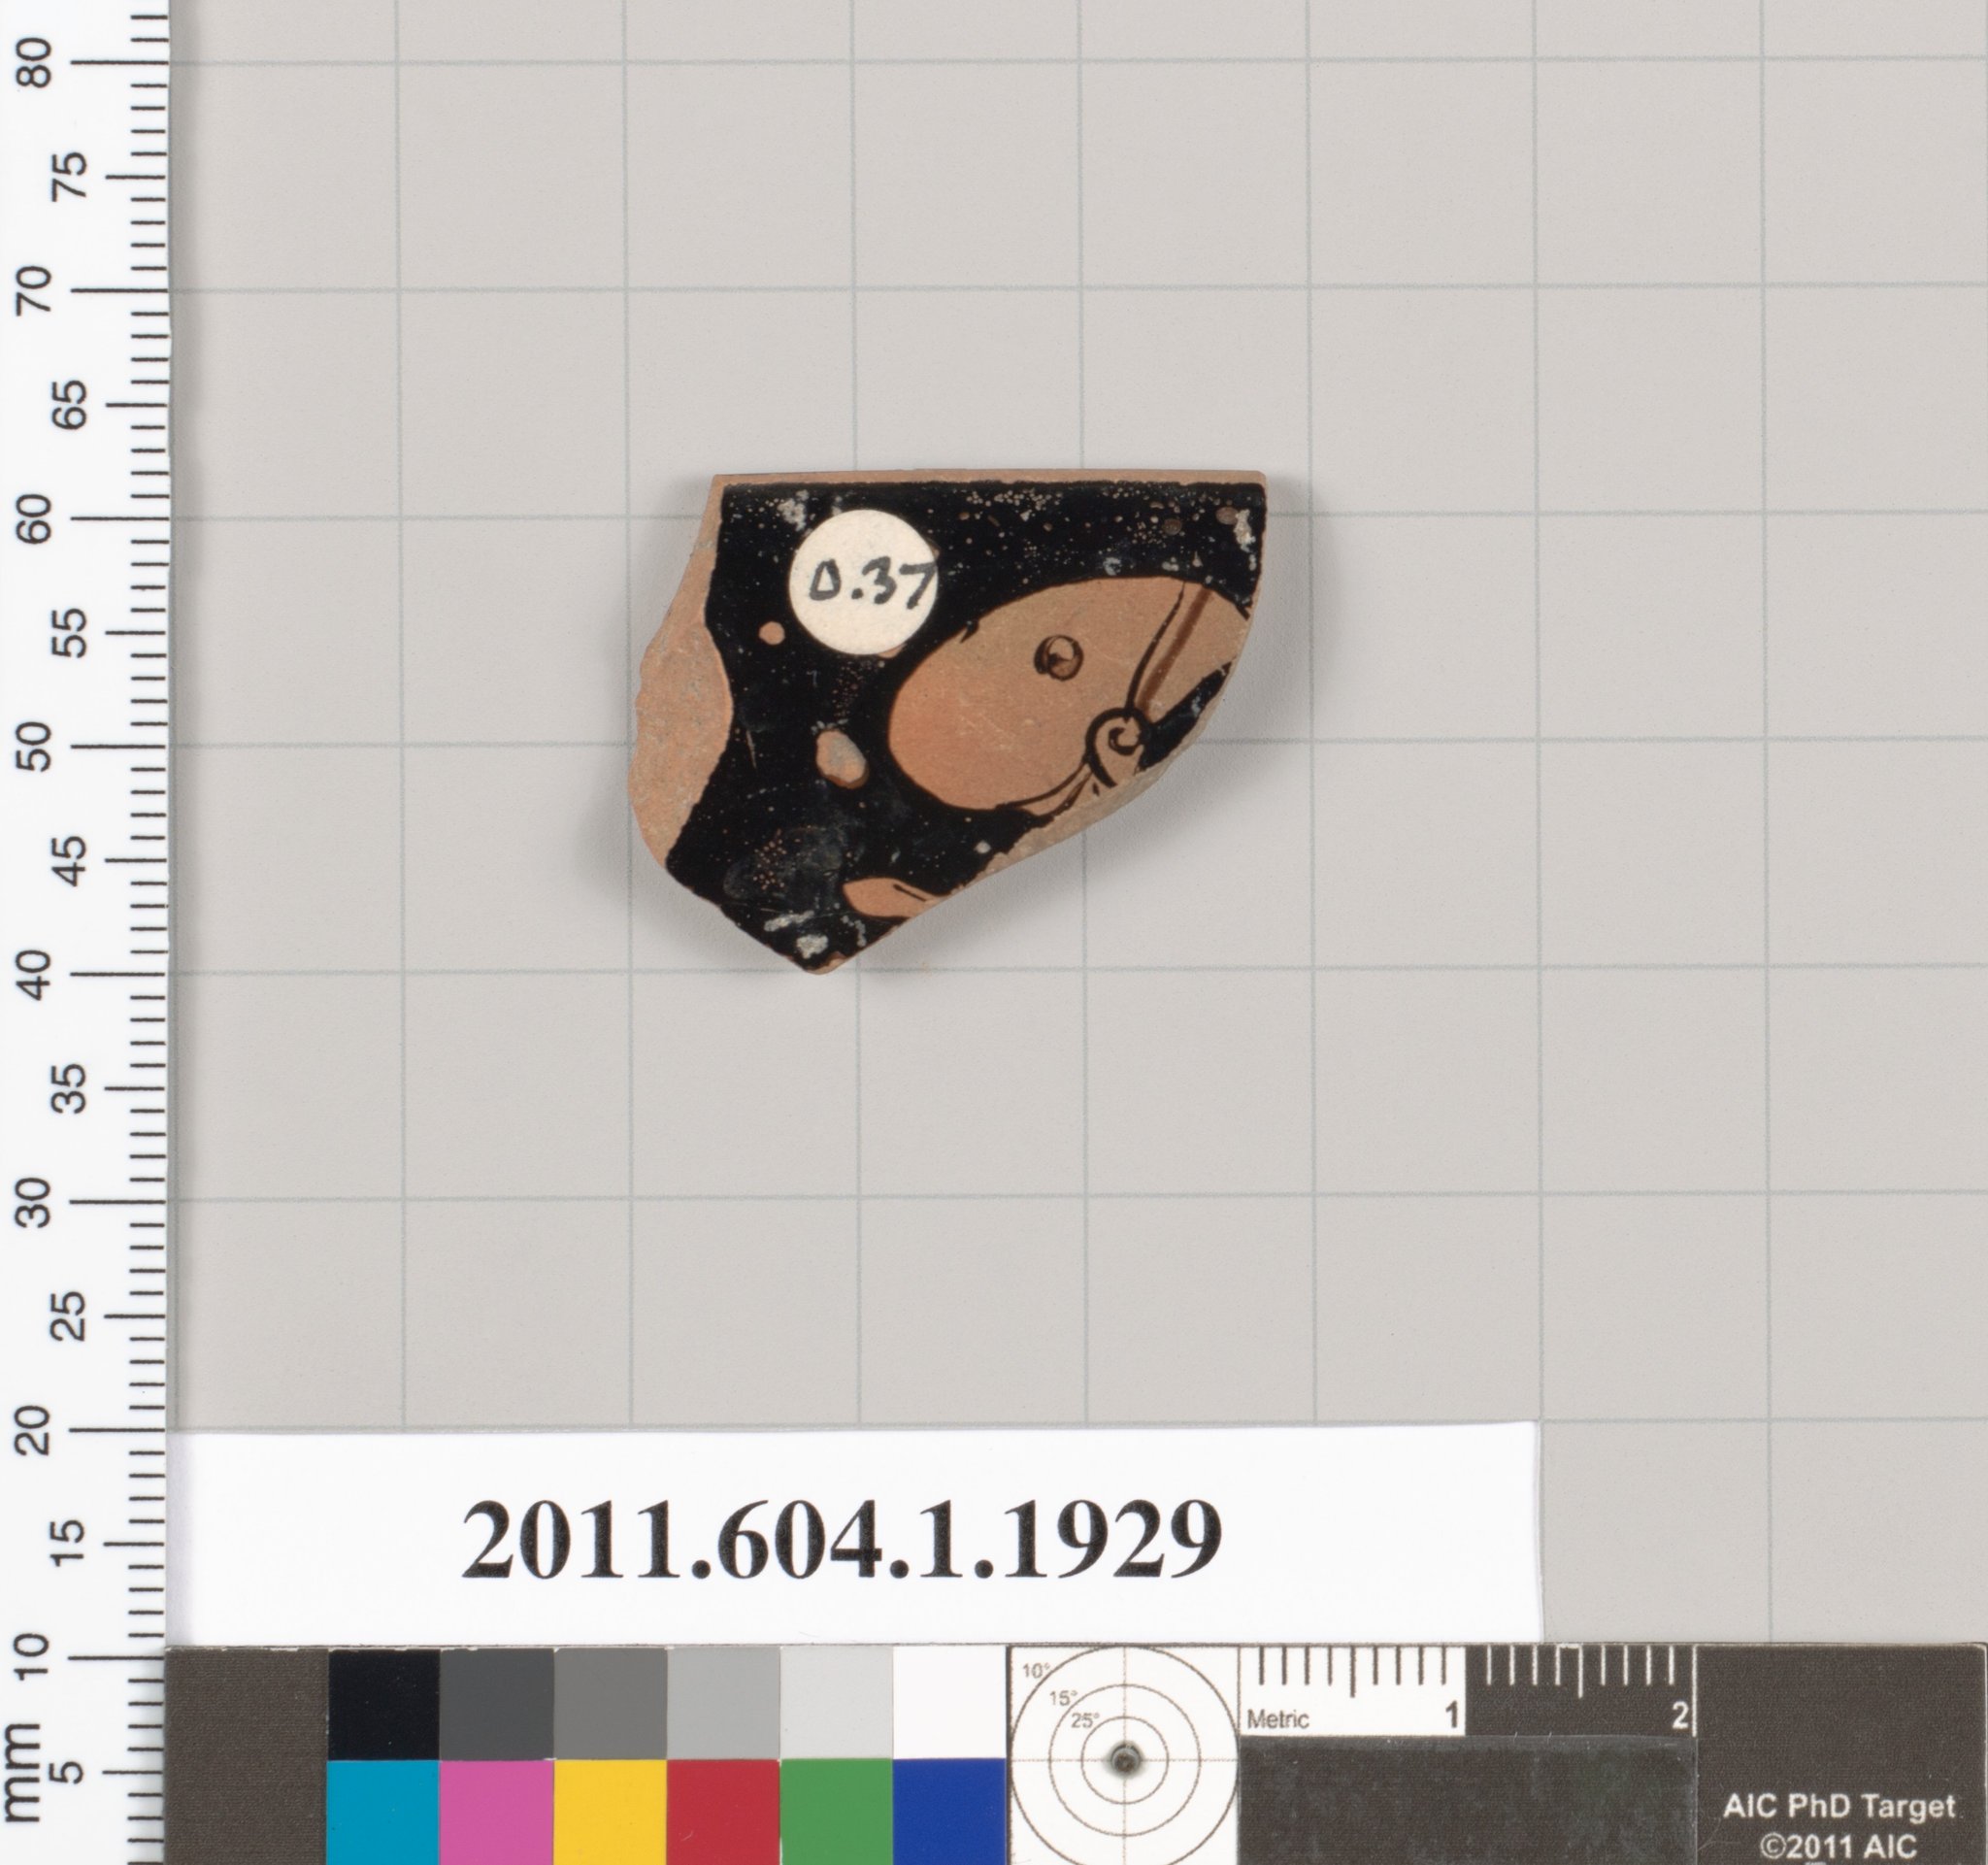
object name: kylix fragment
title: Terracotta rim fragment of a kylix (drinking cup)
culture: greek, attic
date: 475-451 BCE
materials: terracotta